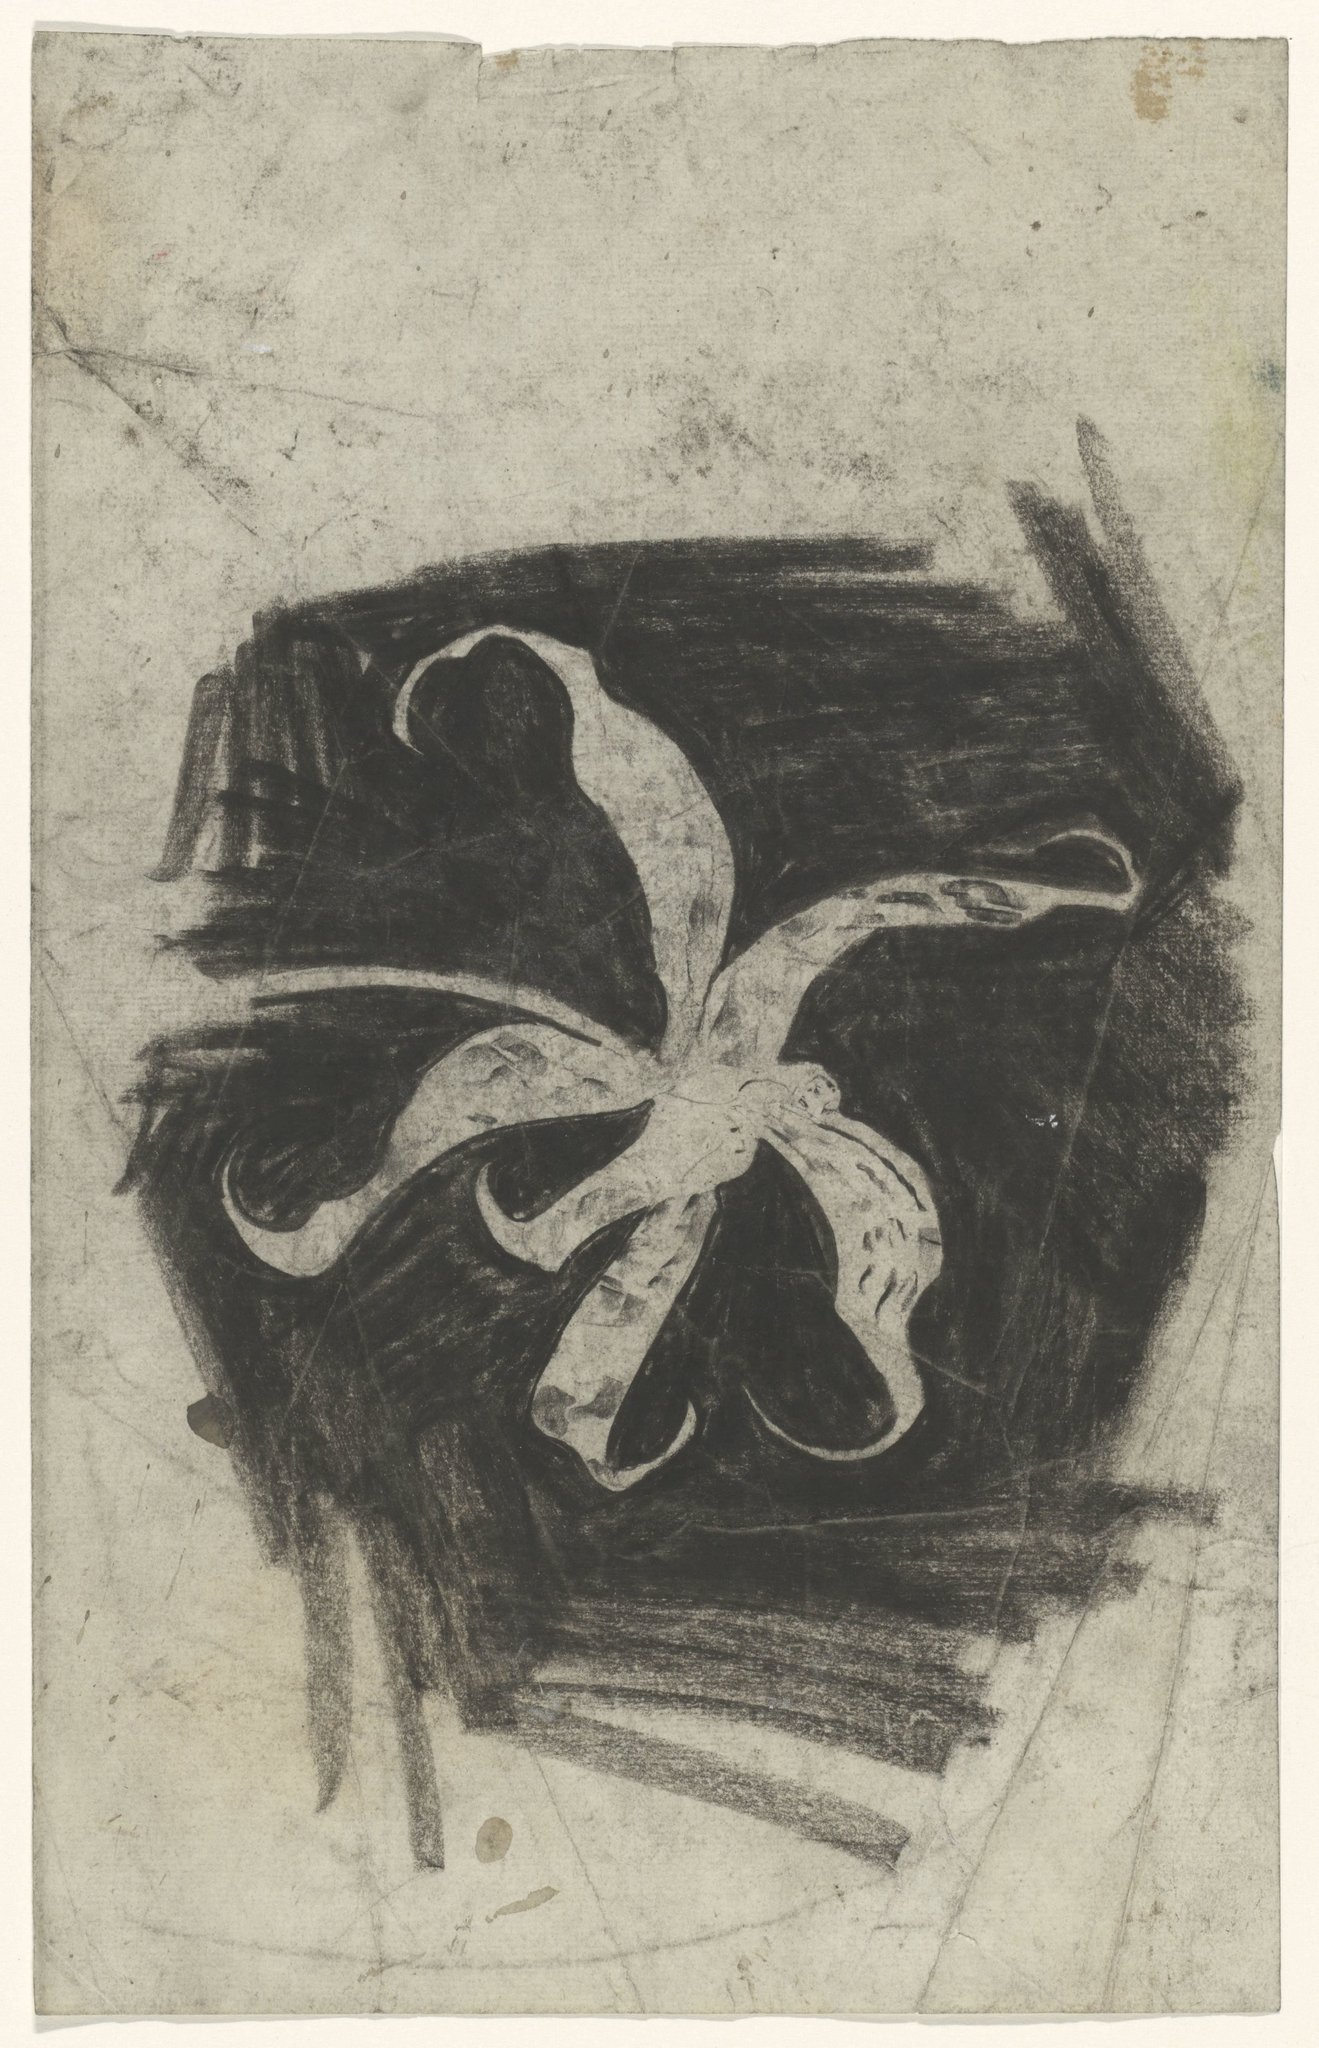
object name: drawing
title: Orchidee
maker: carel adolph lion cachet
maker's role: draughtsman, print maker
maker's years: 1864-1945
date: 1874-1945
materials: charcoal, paper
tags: flowers: orchid